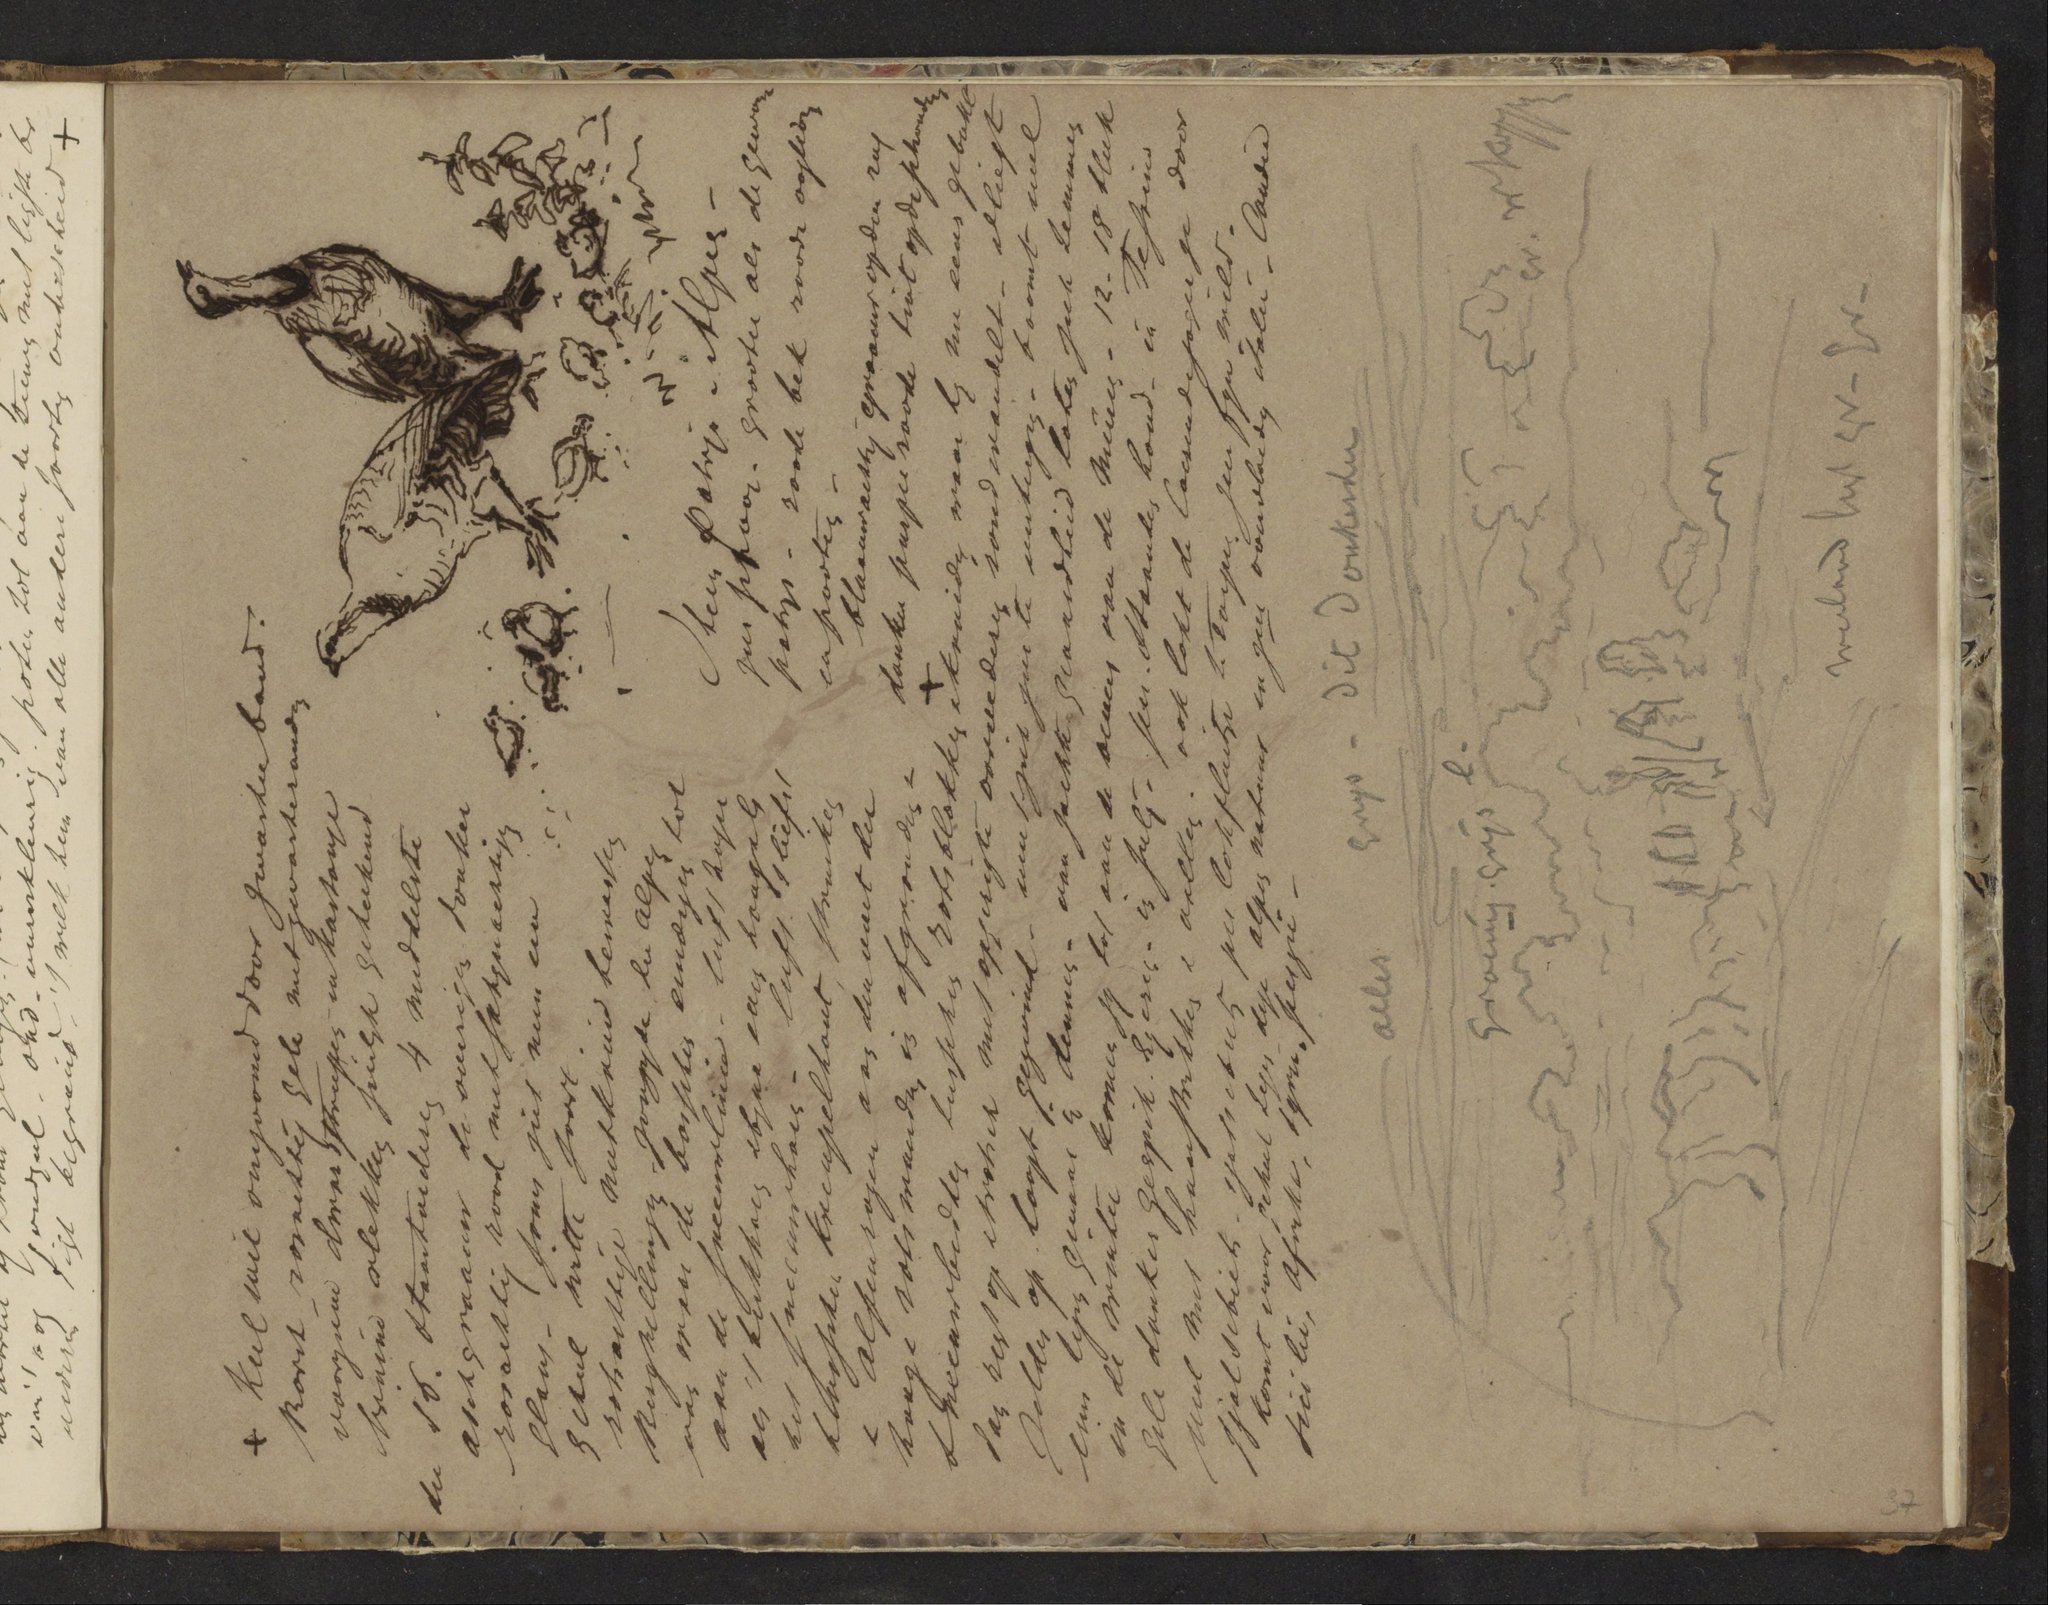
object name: sketchbook leaf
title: Heuvellandschap en twee patrijzen met jongen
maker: johannes tavenraat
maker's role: draughtsman, painter, print maker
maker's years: 1809-1881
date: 1833-1841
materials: ink, paper, pencil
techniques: pen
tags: low hill country, walker and runner birds: partridge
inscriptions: annotation: ‘[...]’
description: Blad 37 recto uit een schetsboek met 41 bladen.